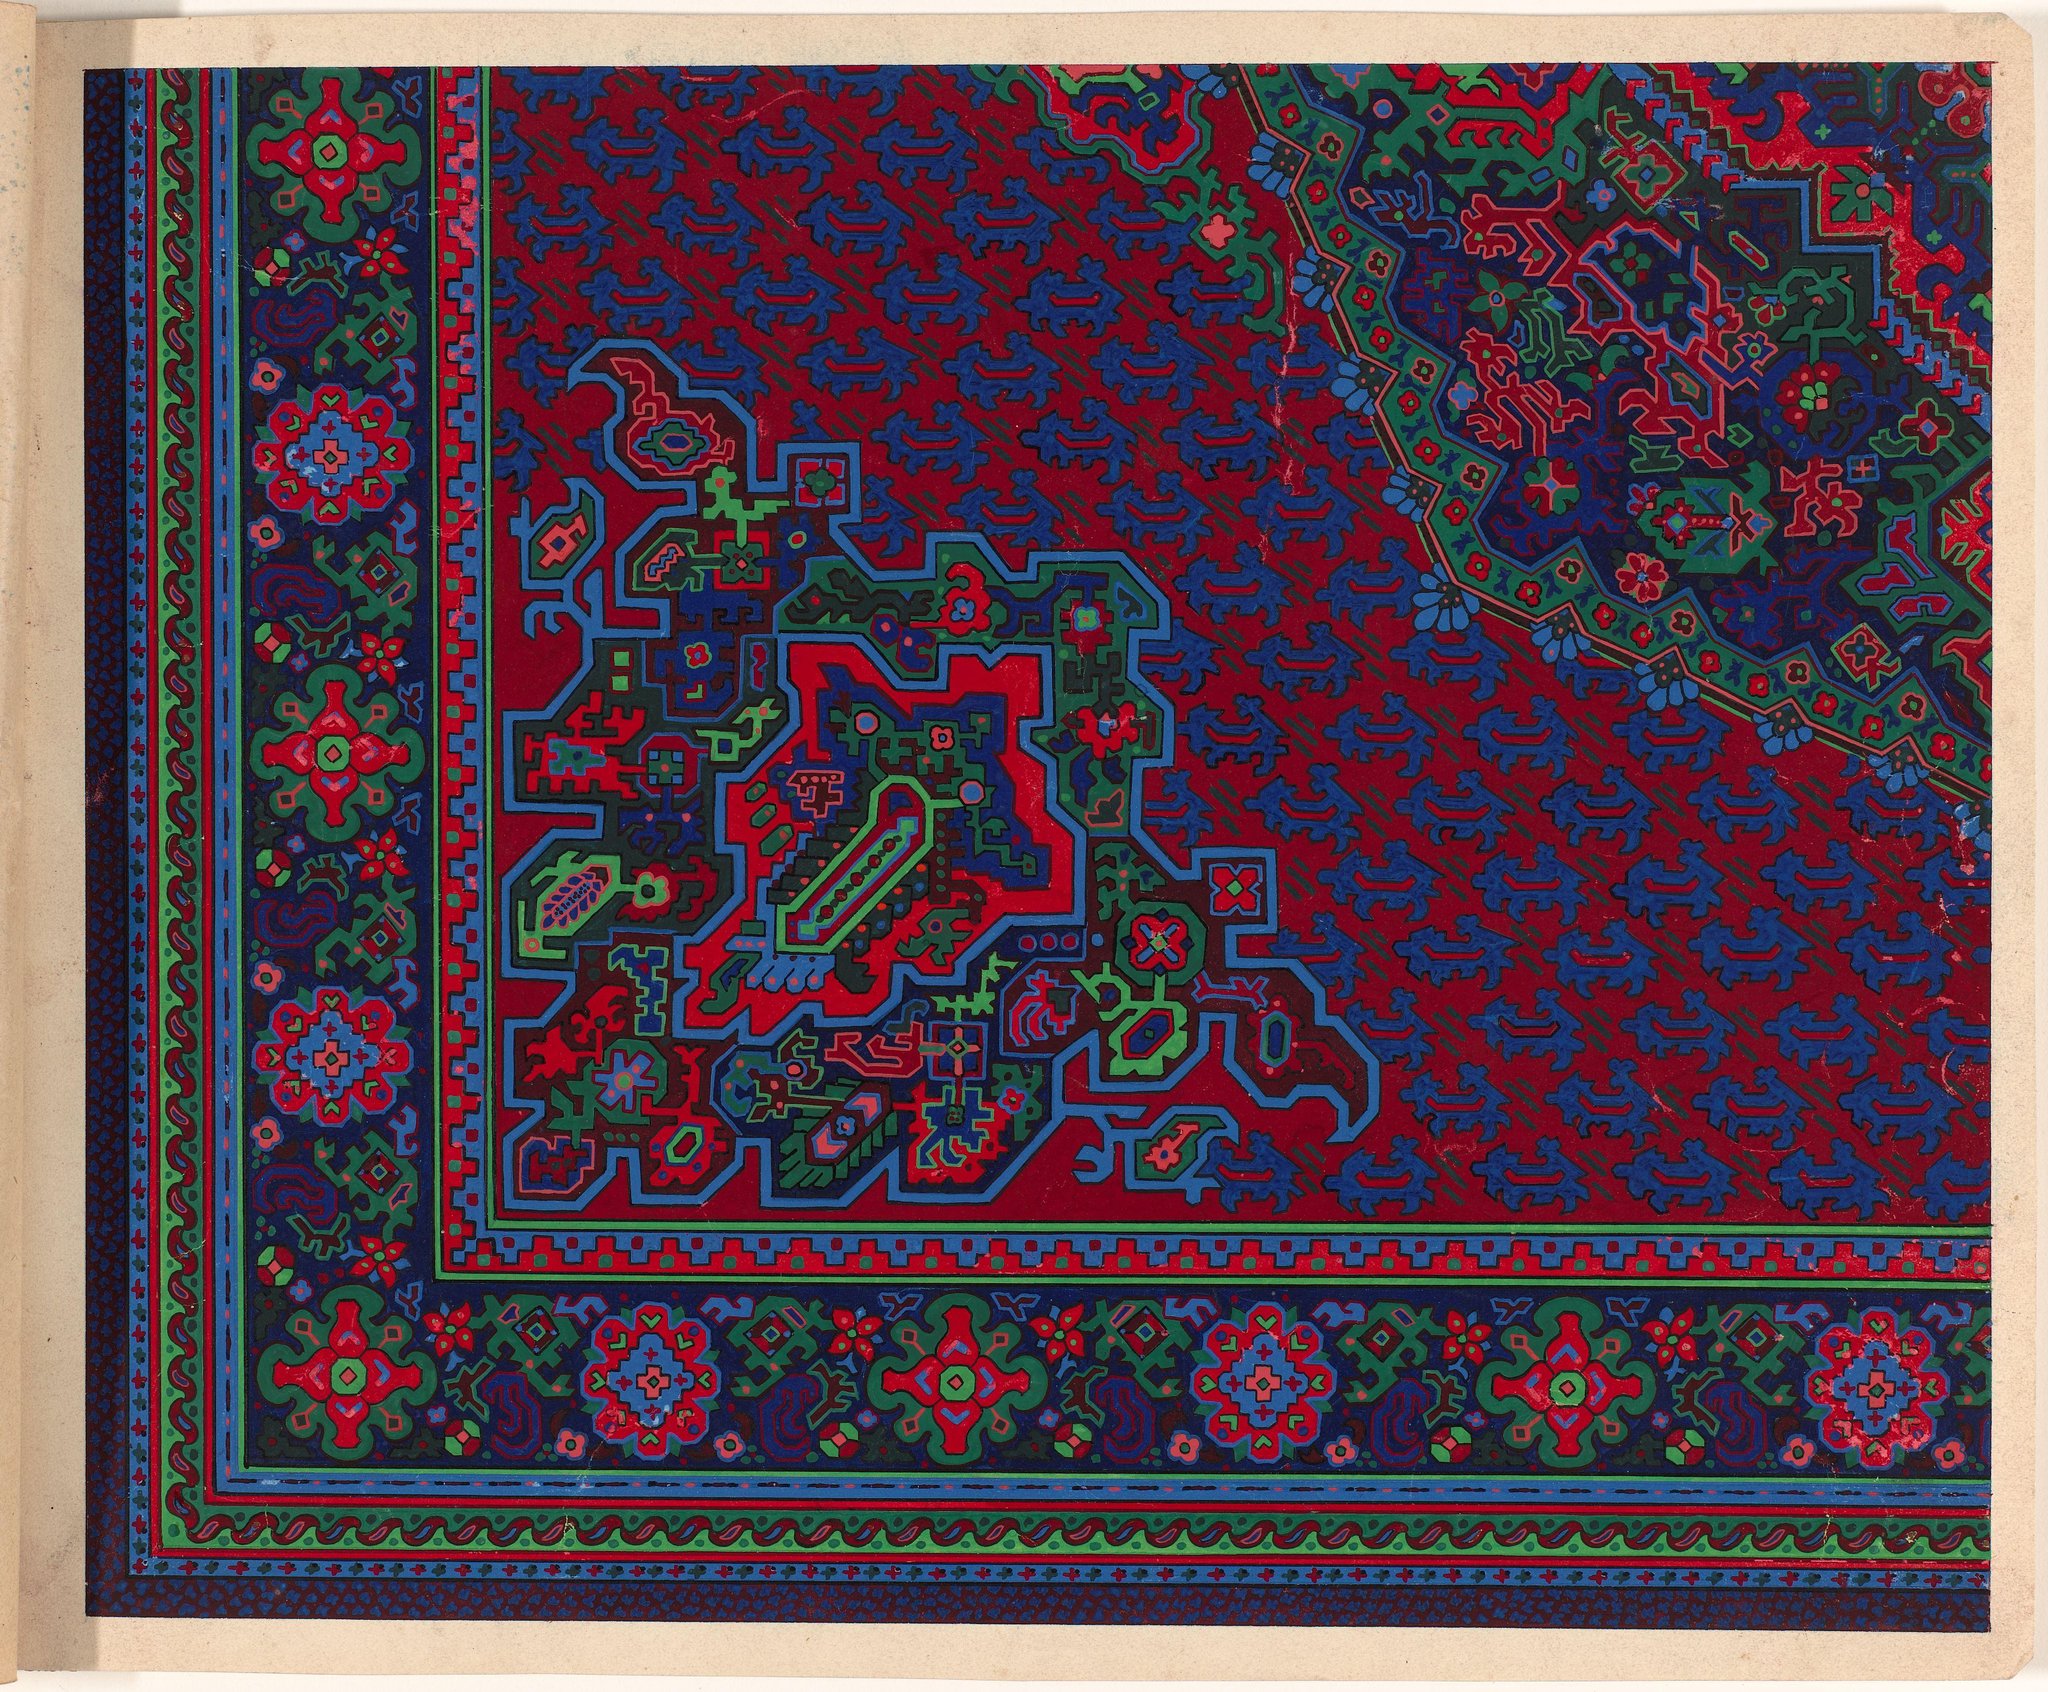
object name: design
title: Ontwerp voor een tapijt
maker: Anonymous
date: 1854-1864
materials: gouache, paper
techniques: brush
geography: deventer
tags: ornaments ~ art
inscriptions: number: ‘N 59.ii’, retailer's mark: ‘JHS.’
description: De presentatietekeningen BK-1971-77-1 t/m 86 zijn kopieën van de originele ontwerptekeningen. Ze werden gemaakt voor vertegenwoordigers van bijvoorbeeld magazijnen, die ze aan hun klanten konden tonen. De meeste tekeningen tonen een kwart van het dessin inclusief rand, middenpartij (de zogenaamde grond of fond) en centraal medaillon. Door het gebruik van spiegels kan de illusie van het gehele tapijt worden opgeroepen. Een deel van de tekeningen heeft een alfabetische opeenvolgende letter als kenmerk, de andere groep een cijfer.Waarschijnlijk is de reeks dessins met een letter eerder samengesteld dan de genummerde tekeningen.